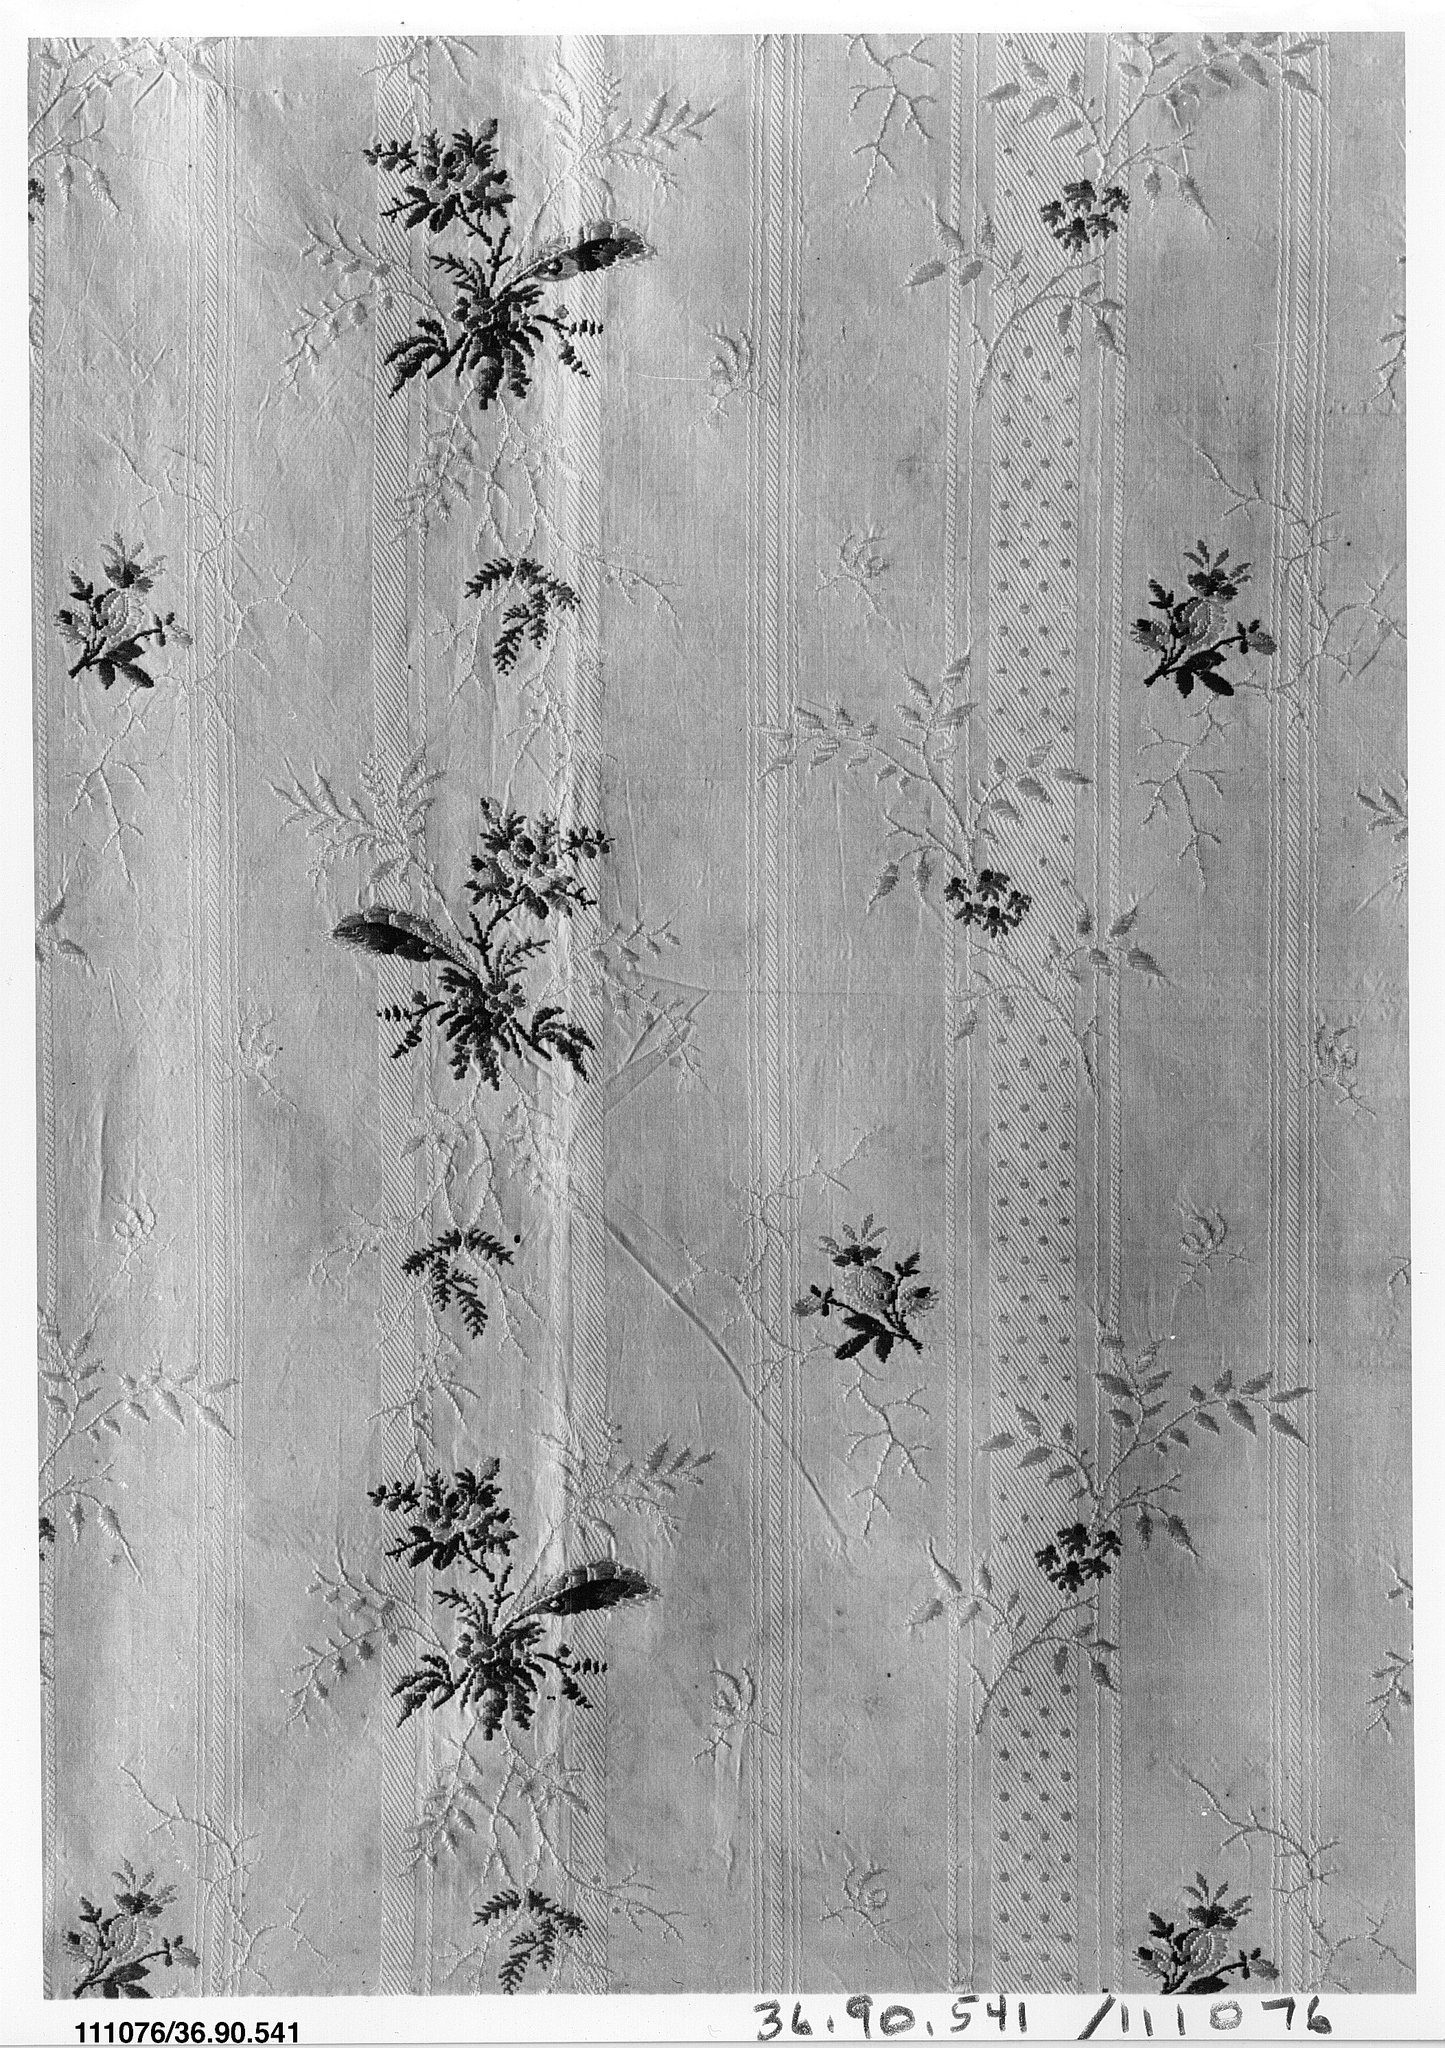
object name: piece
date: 1767-1800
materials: silk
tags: flowers,leaves